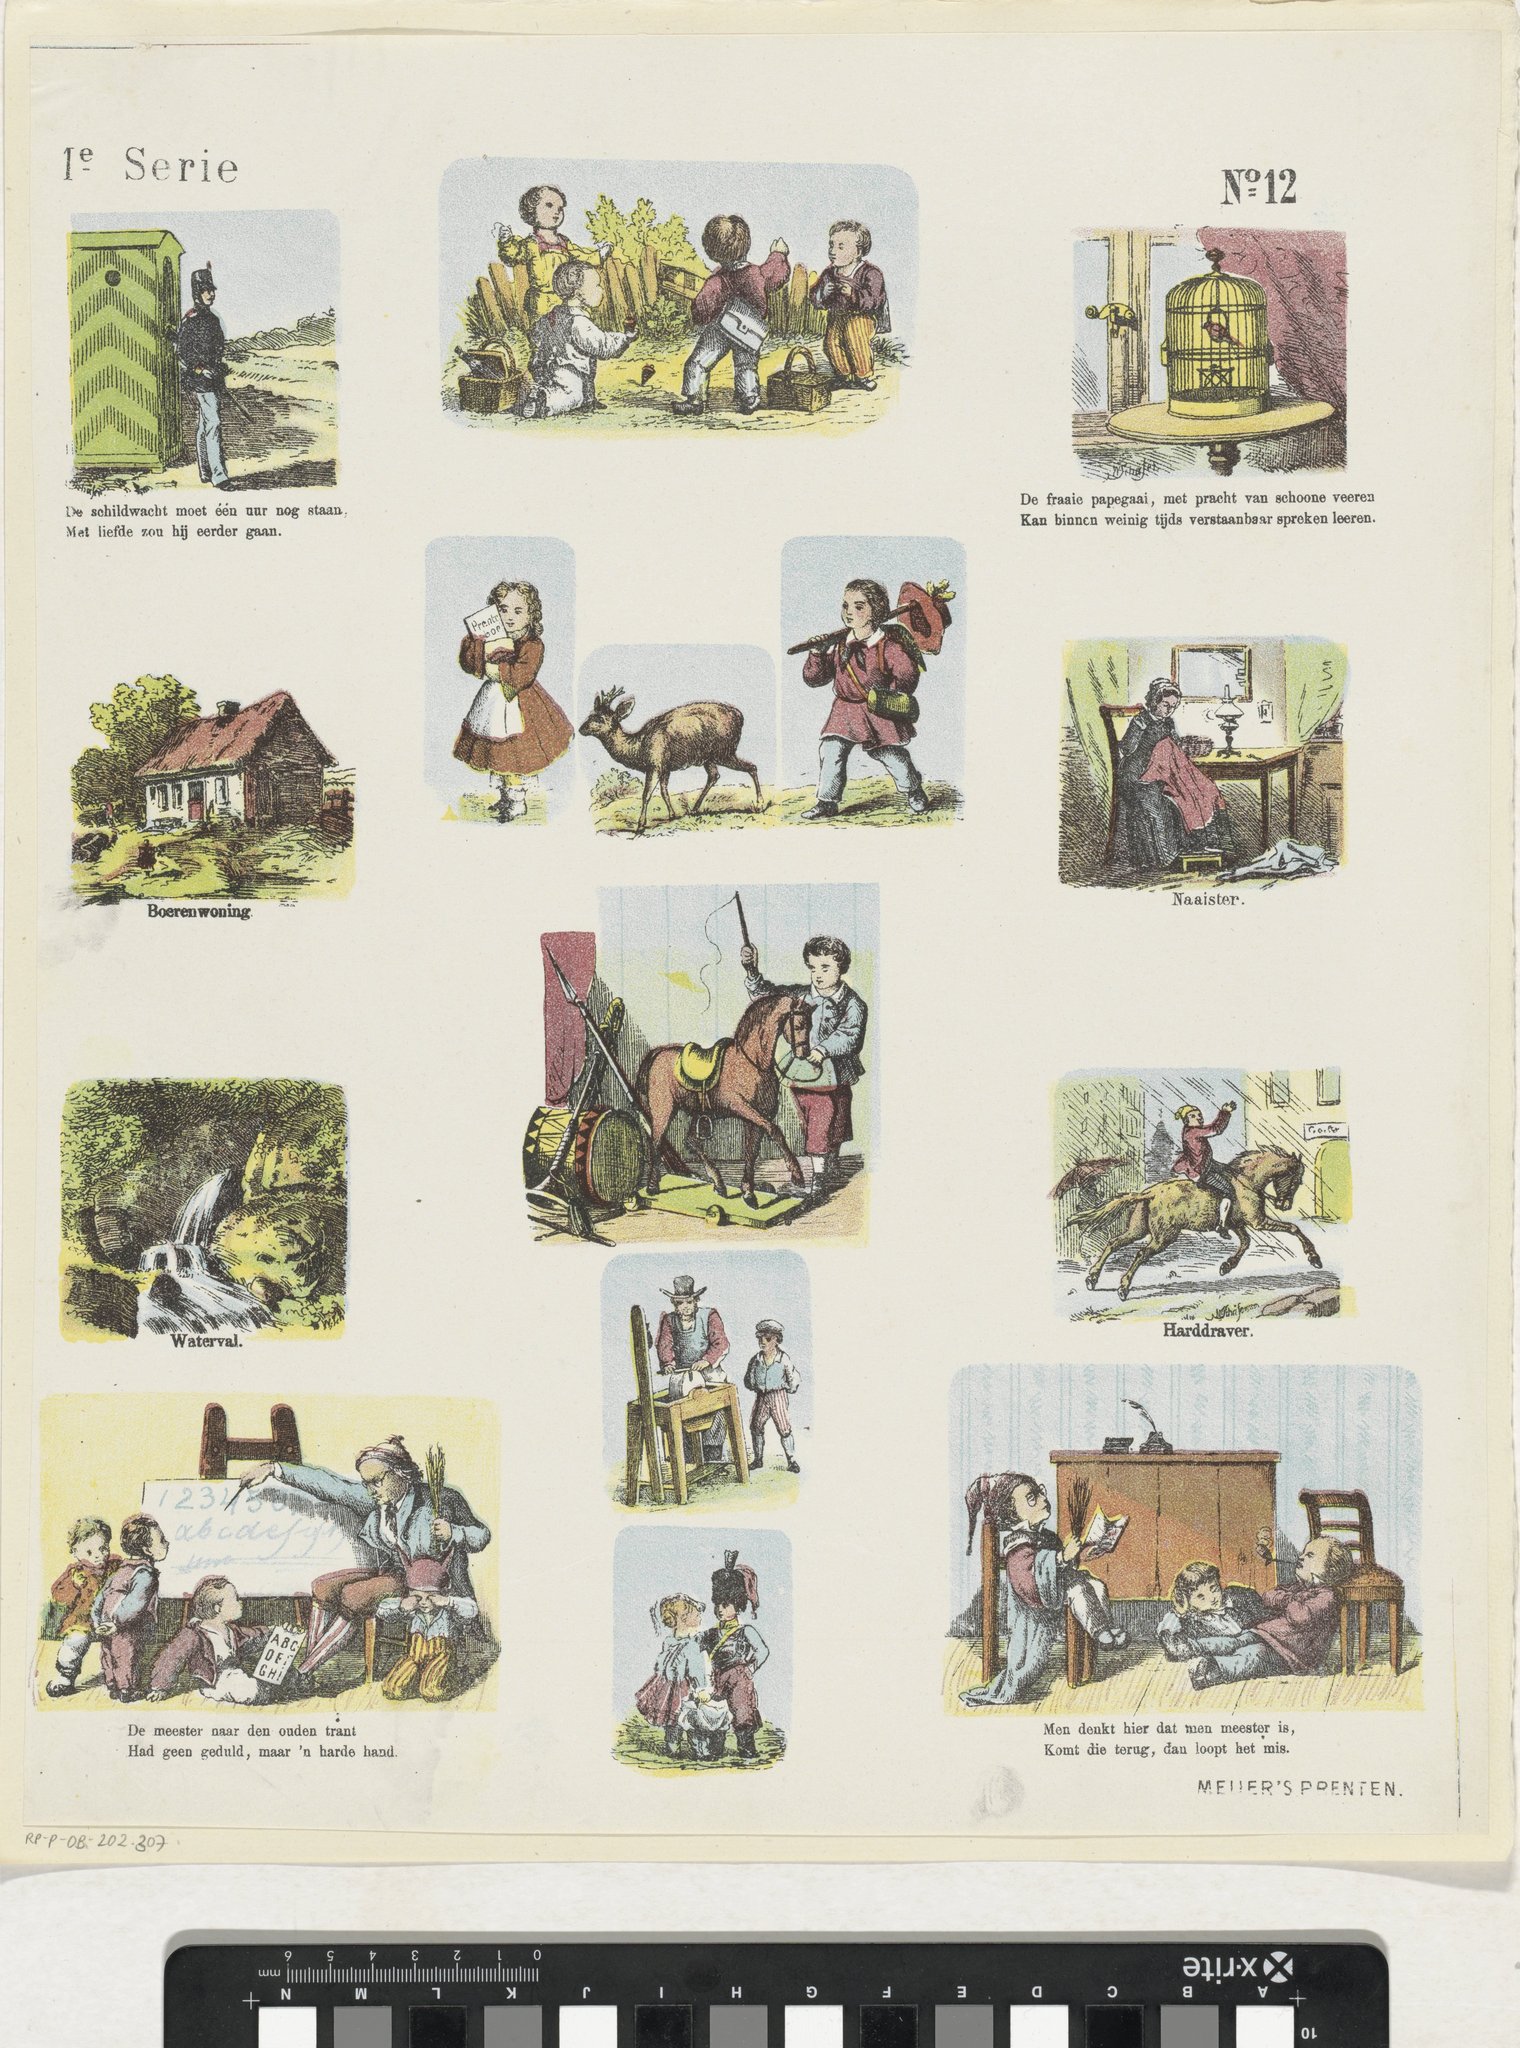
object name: print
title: Verschillende taferelen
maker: Anonymous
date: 1873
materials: paper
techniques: lithograph, letterpress printing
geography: amsterdam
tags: children's games and plays, crafts and industries, guard duty, keeping sentry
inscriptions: collector's mark: Lugt 2760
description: Blad met 15 voorstellingen van verschillende aard, waaronder een schildwacht, spelende kinderen en een naaister. Onder enkele afbeeldingen een onderschrift. Genummerd rechtsboven: No. 12.